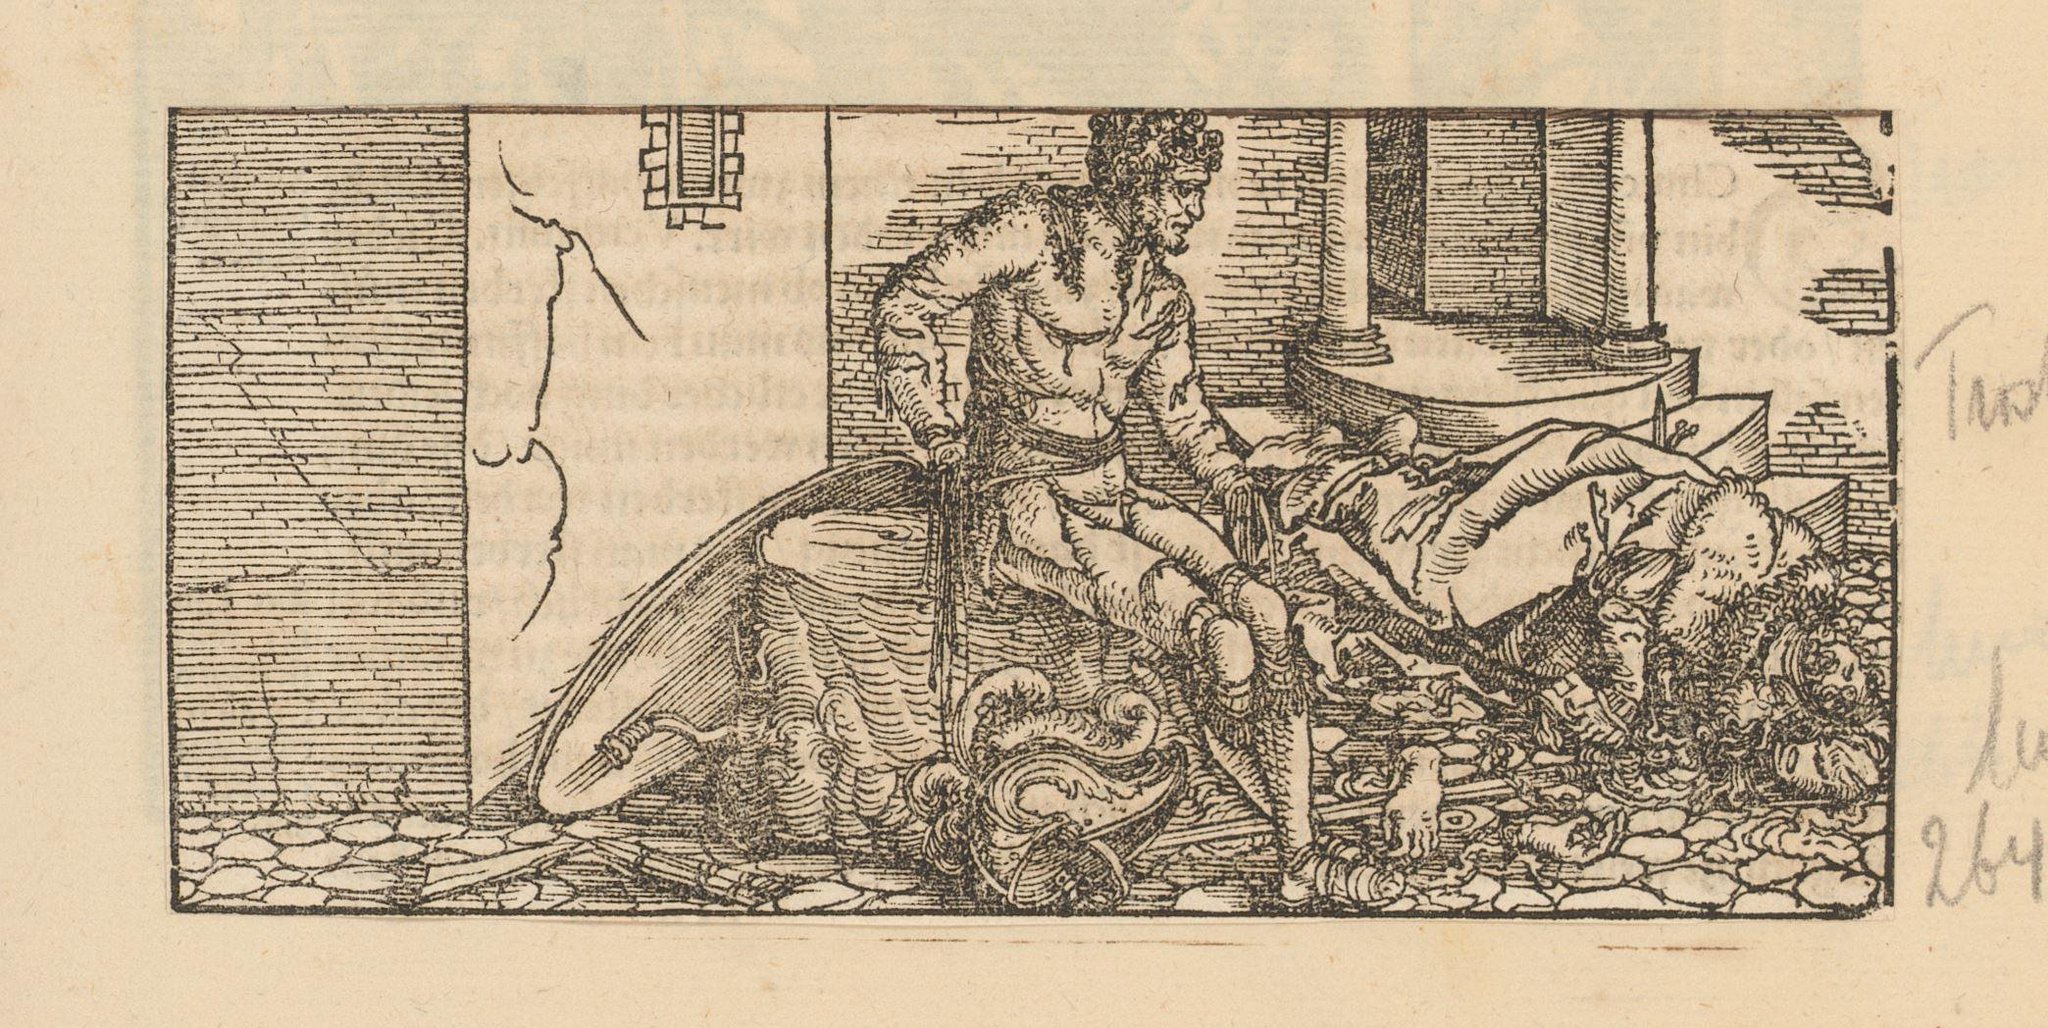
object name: book illustration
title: Zwaargewonde soldaten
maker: Anonymous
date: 1514-1532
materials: paper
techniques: letterpress printing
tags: infections and wounds, disabled soldier, violent death, being killed; being mishandled and maltreated; seeking death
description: Deze prent is gebruikt in: Petrarca, Francesco. Von der Artzney bayder Glück, des guten und widerwertigen: unnd weß sich ain yeder inn Gelück und Unglück halten sol (...). Augsburg: Heinrich Steiner, 1532. Deze uitgave is ook bekend onder de titel 'Trostspiegel in Glück und Unglück'.